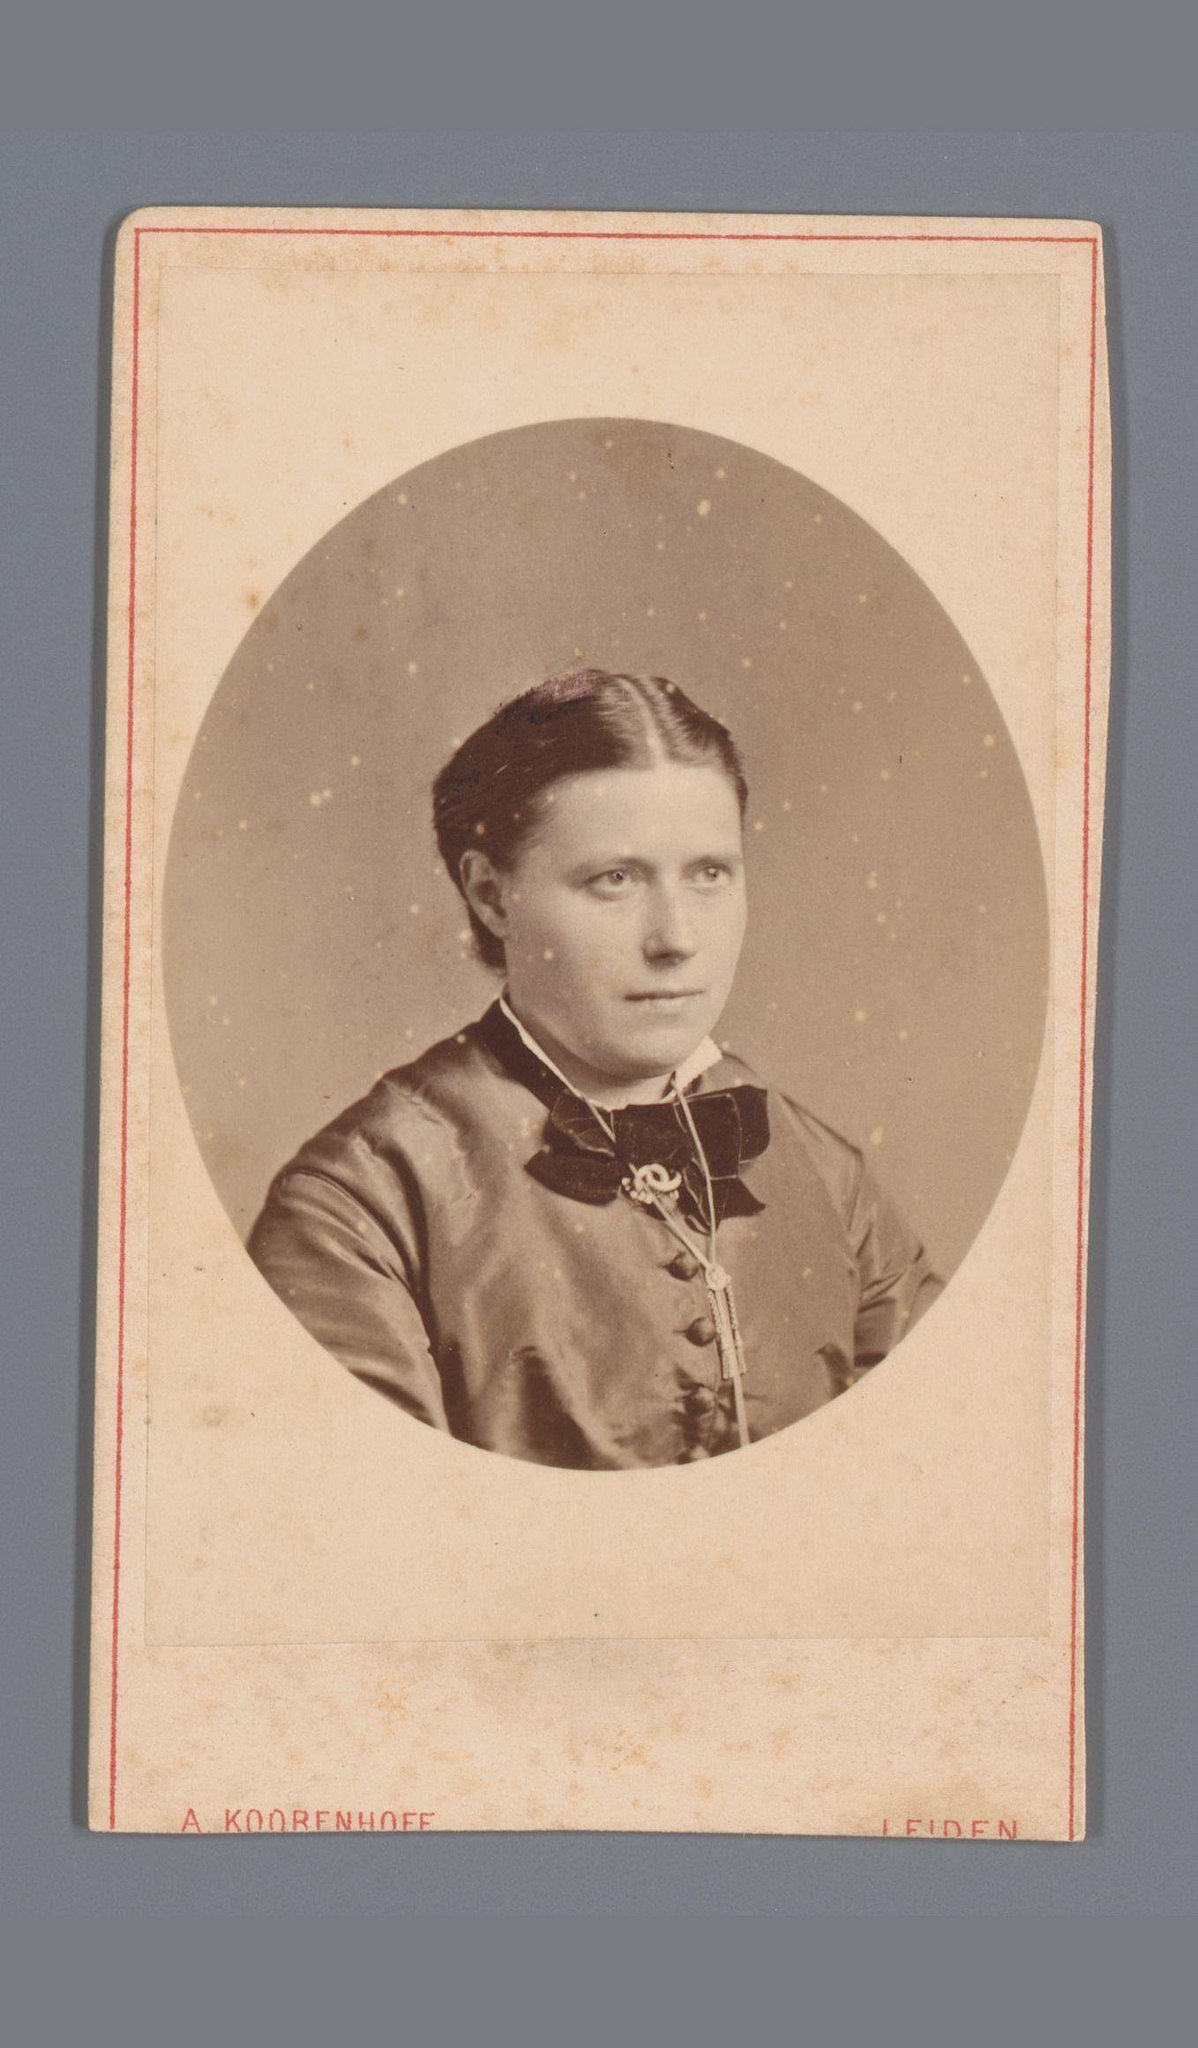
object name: carte de visite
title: Portret van Jet van de Boom Eschauzier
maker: abraham koorenhoff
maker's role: fotograaf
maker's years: 1844-1917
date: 1892-1893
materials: cardboard, photographic support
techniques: albumen print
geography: leiden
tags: historical persons, leiden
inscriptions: annotation: ‘Tante Jet van de Boom-Eschauzier’, workshop stamp: ‘A. Koorenhoff/ Photgraphe van Z.M. den Koning der Nederlanden/ te Leiden, Gerecht No.5 by de Pieterskerk’